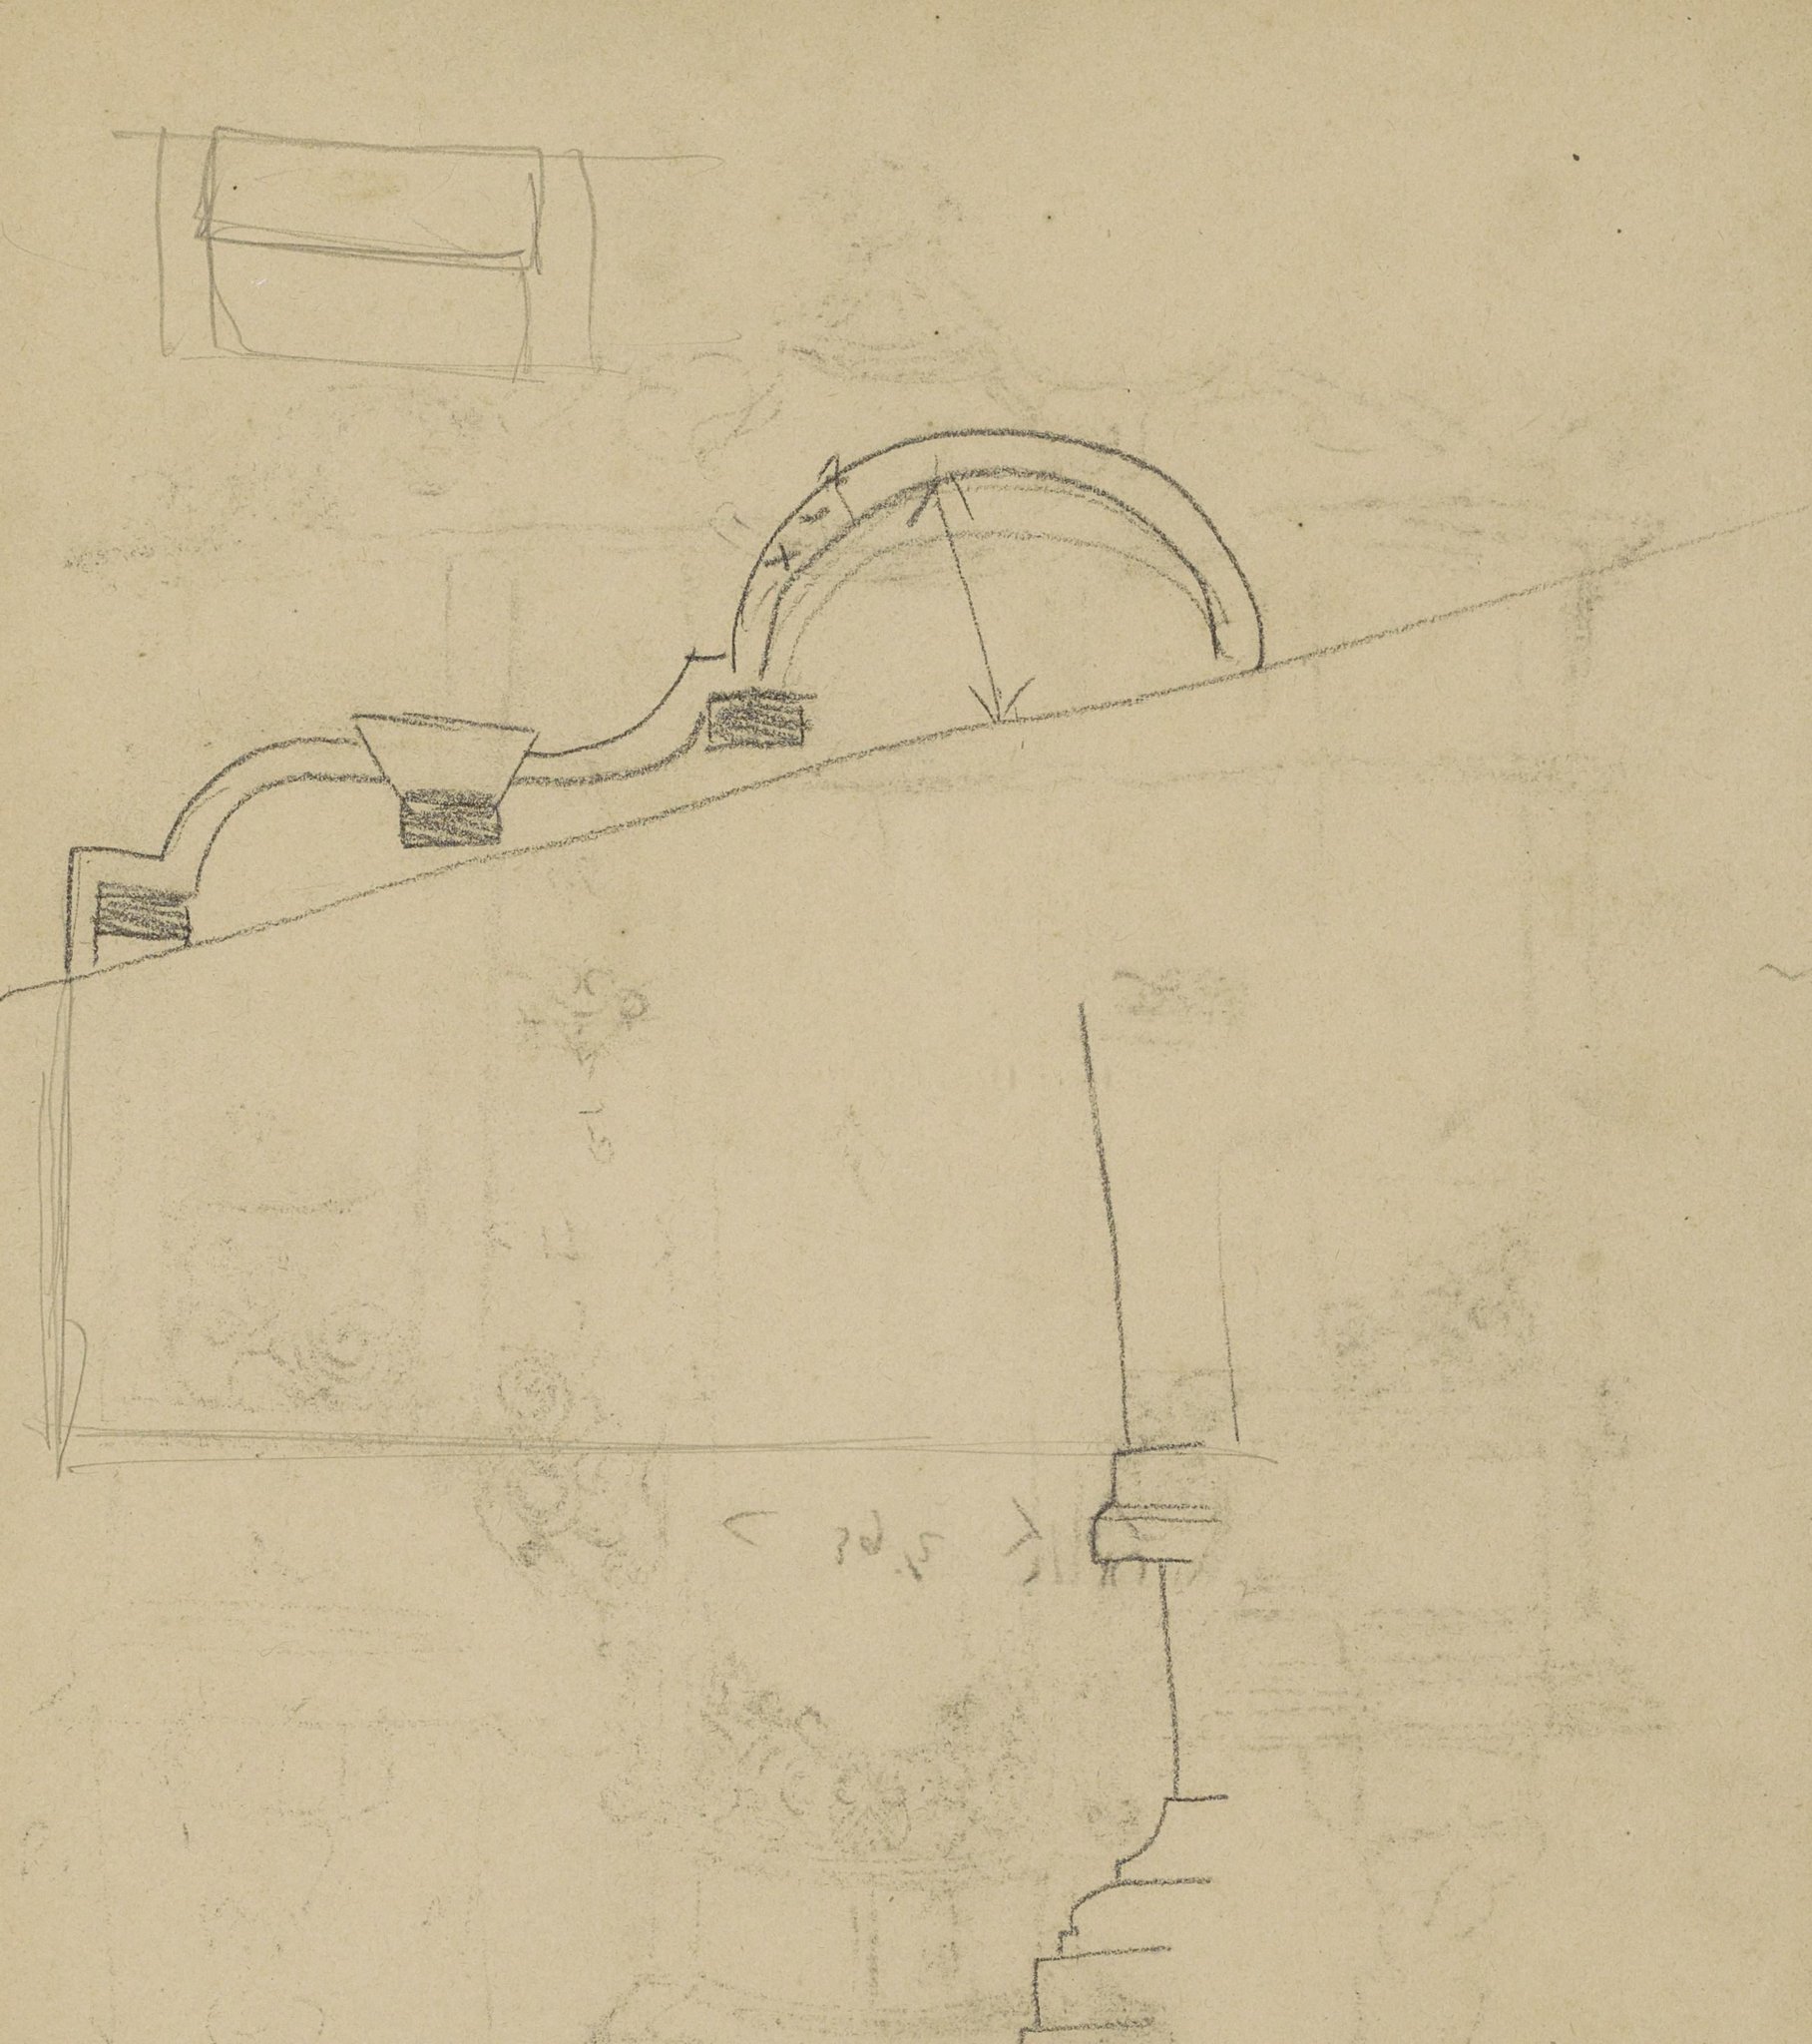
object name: sketchbook leaf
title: Architectuurstudies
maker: carel adolph lion cachet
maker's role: draughtsman, print maker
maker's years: 1864-1945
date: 1905-1906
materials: chalk, paper, pencil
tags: architecture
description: Blad 30 recto uit een schetsboek met 30 bladen.